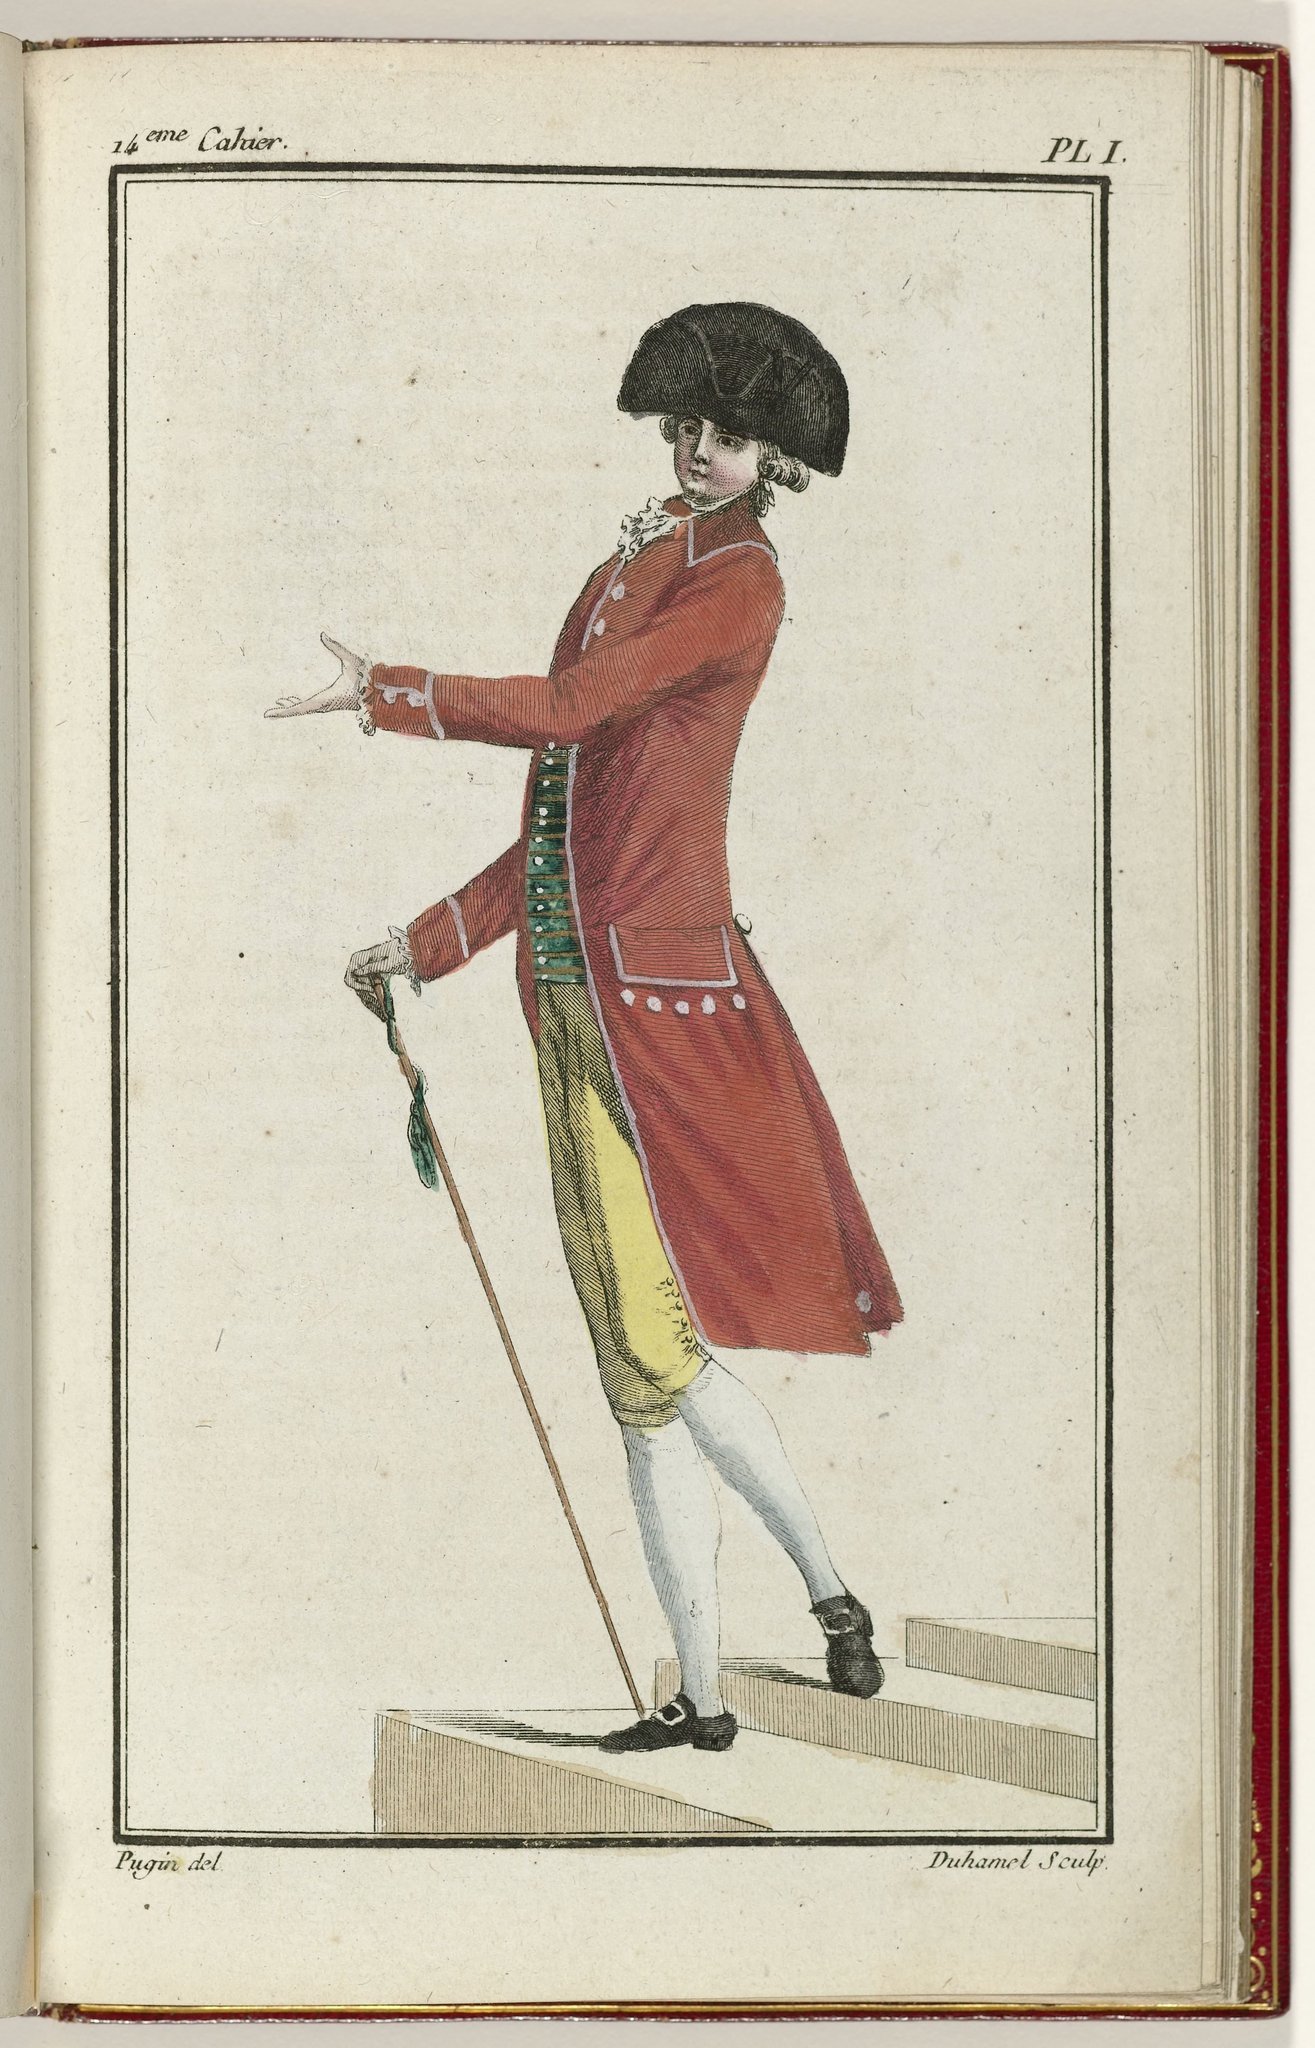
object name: fashion print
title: Cabinet des Modes ou les Modes Nouvelles, 1 Juin 1786, pl. I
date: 1786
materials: paper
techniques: engraving, hand coloring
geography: paris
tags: clothing for the upper part of the body (vest) (+ men's clothes), head-gear, button (+ men's clothes), coat (+ men's clothes), fashion plates, trousers, breeches, etc. (breeches) (+ men's clothes), stockings, socks (+ men's clothes), walking-stick, staff, cane (+ men's clothes), buckle (+ men's clothes)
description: Jongeman in een 'habit' van scharlakenrood laken. Volgens de begeleidende tekst is de jas gevoerd met witte zijde en zijn er grote witte knopen van parelmoer op bevestigd. De uiteinden van de mouwen zijn geopend 'à la Marinière' en met twee dezelfde knopen aan de zijkant gesloten. Vier knopen op de zakken van de jas. Kraag van dezelfde stof. Onder de jas een zeegroen vest van zware zijde ('Gros-de-Tour') met goudkleurige strepen; versierd met kleine witte knopen. 'Culotte' of kniebroek van licht citroengeel kasjmier, met een rij knoopjes aan de onderkant. Witte zijden kousen. Schoenen met zilveren schoengespen. Op het hoofd een hoed `à l'Androsmane'. Wandelstok van bamboe in de hand. De prent maakt deel uit van het 14e Cahier uit de serie Cabinet des Modes ou les Modes Nouvelles. De serie bestaat uit 72 modeprenten, uitgegeven door Buisson, Parijs, 15 november 1785 - 1 november 1786.